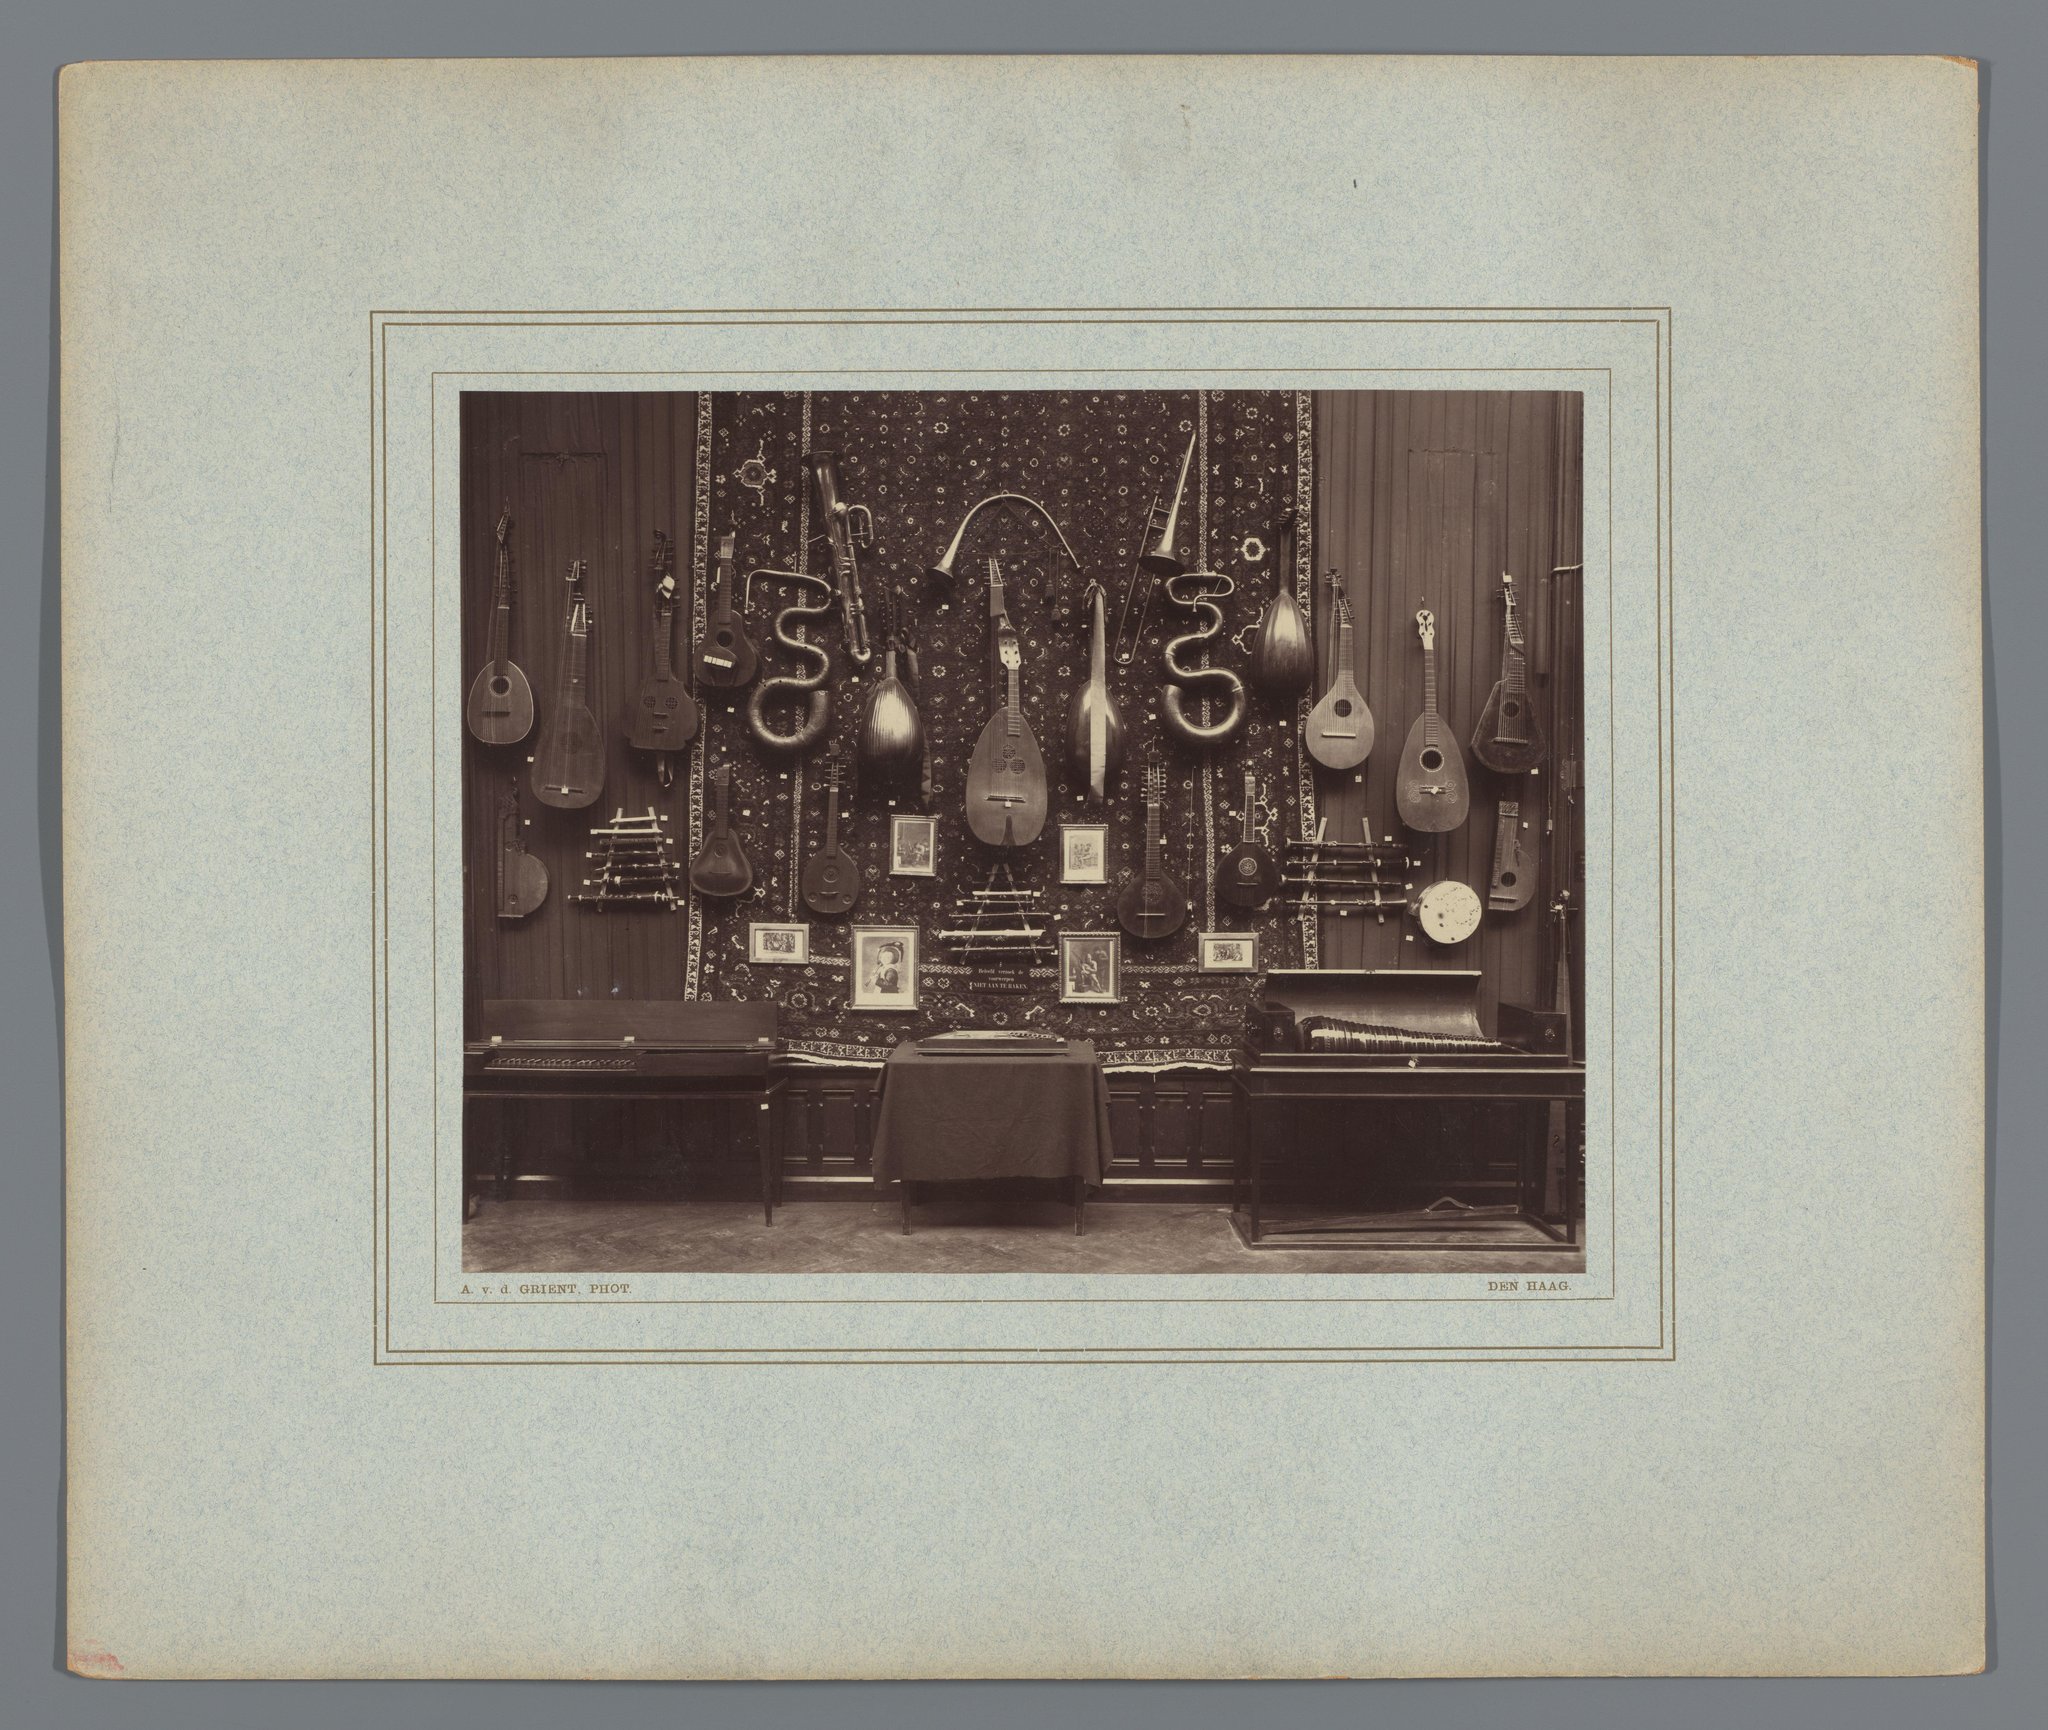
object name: photomechanical print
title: Muziekinstrumenten uit de collectie Daniël François Scheurleer, tentoongesteld in Pulchri Studio in 1893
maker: adrianus van der grient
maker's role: fotograaf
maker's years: 1858-1941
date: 1893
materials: cardboard, paper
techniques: woodburytype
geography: pulchri studio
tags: the hague, daniël françois lunsingh scheurleer, percussion instruments, string instruments (plucked), exhibition ~ art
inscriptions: inscription: ‘A. v. d. GRIENT, PHOT. - DEN HAAG.’